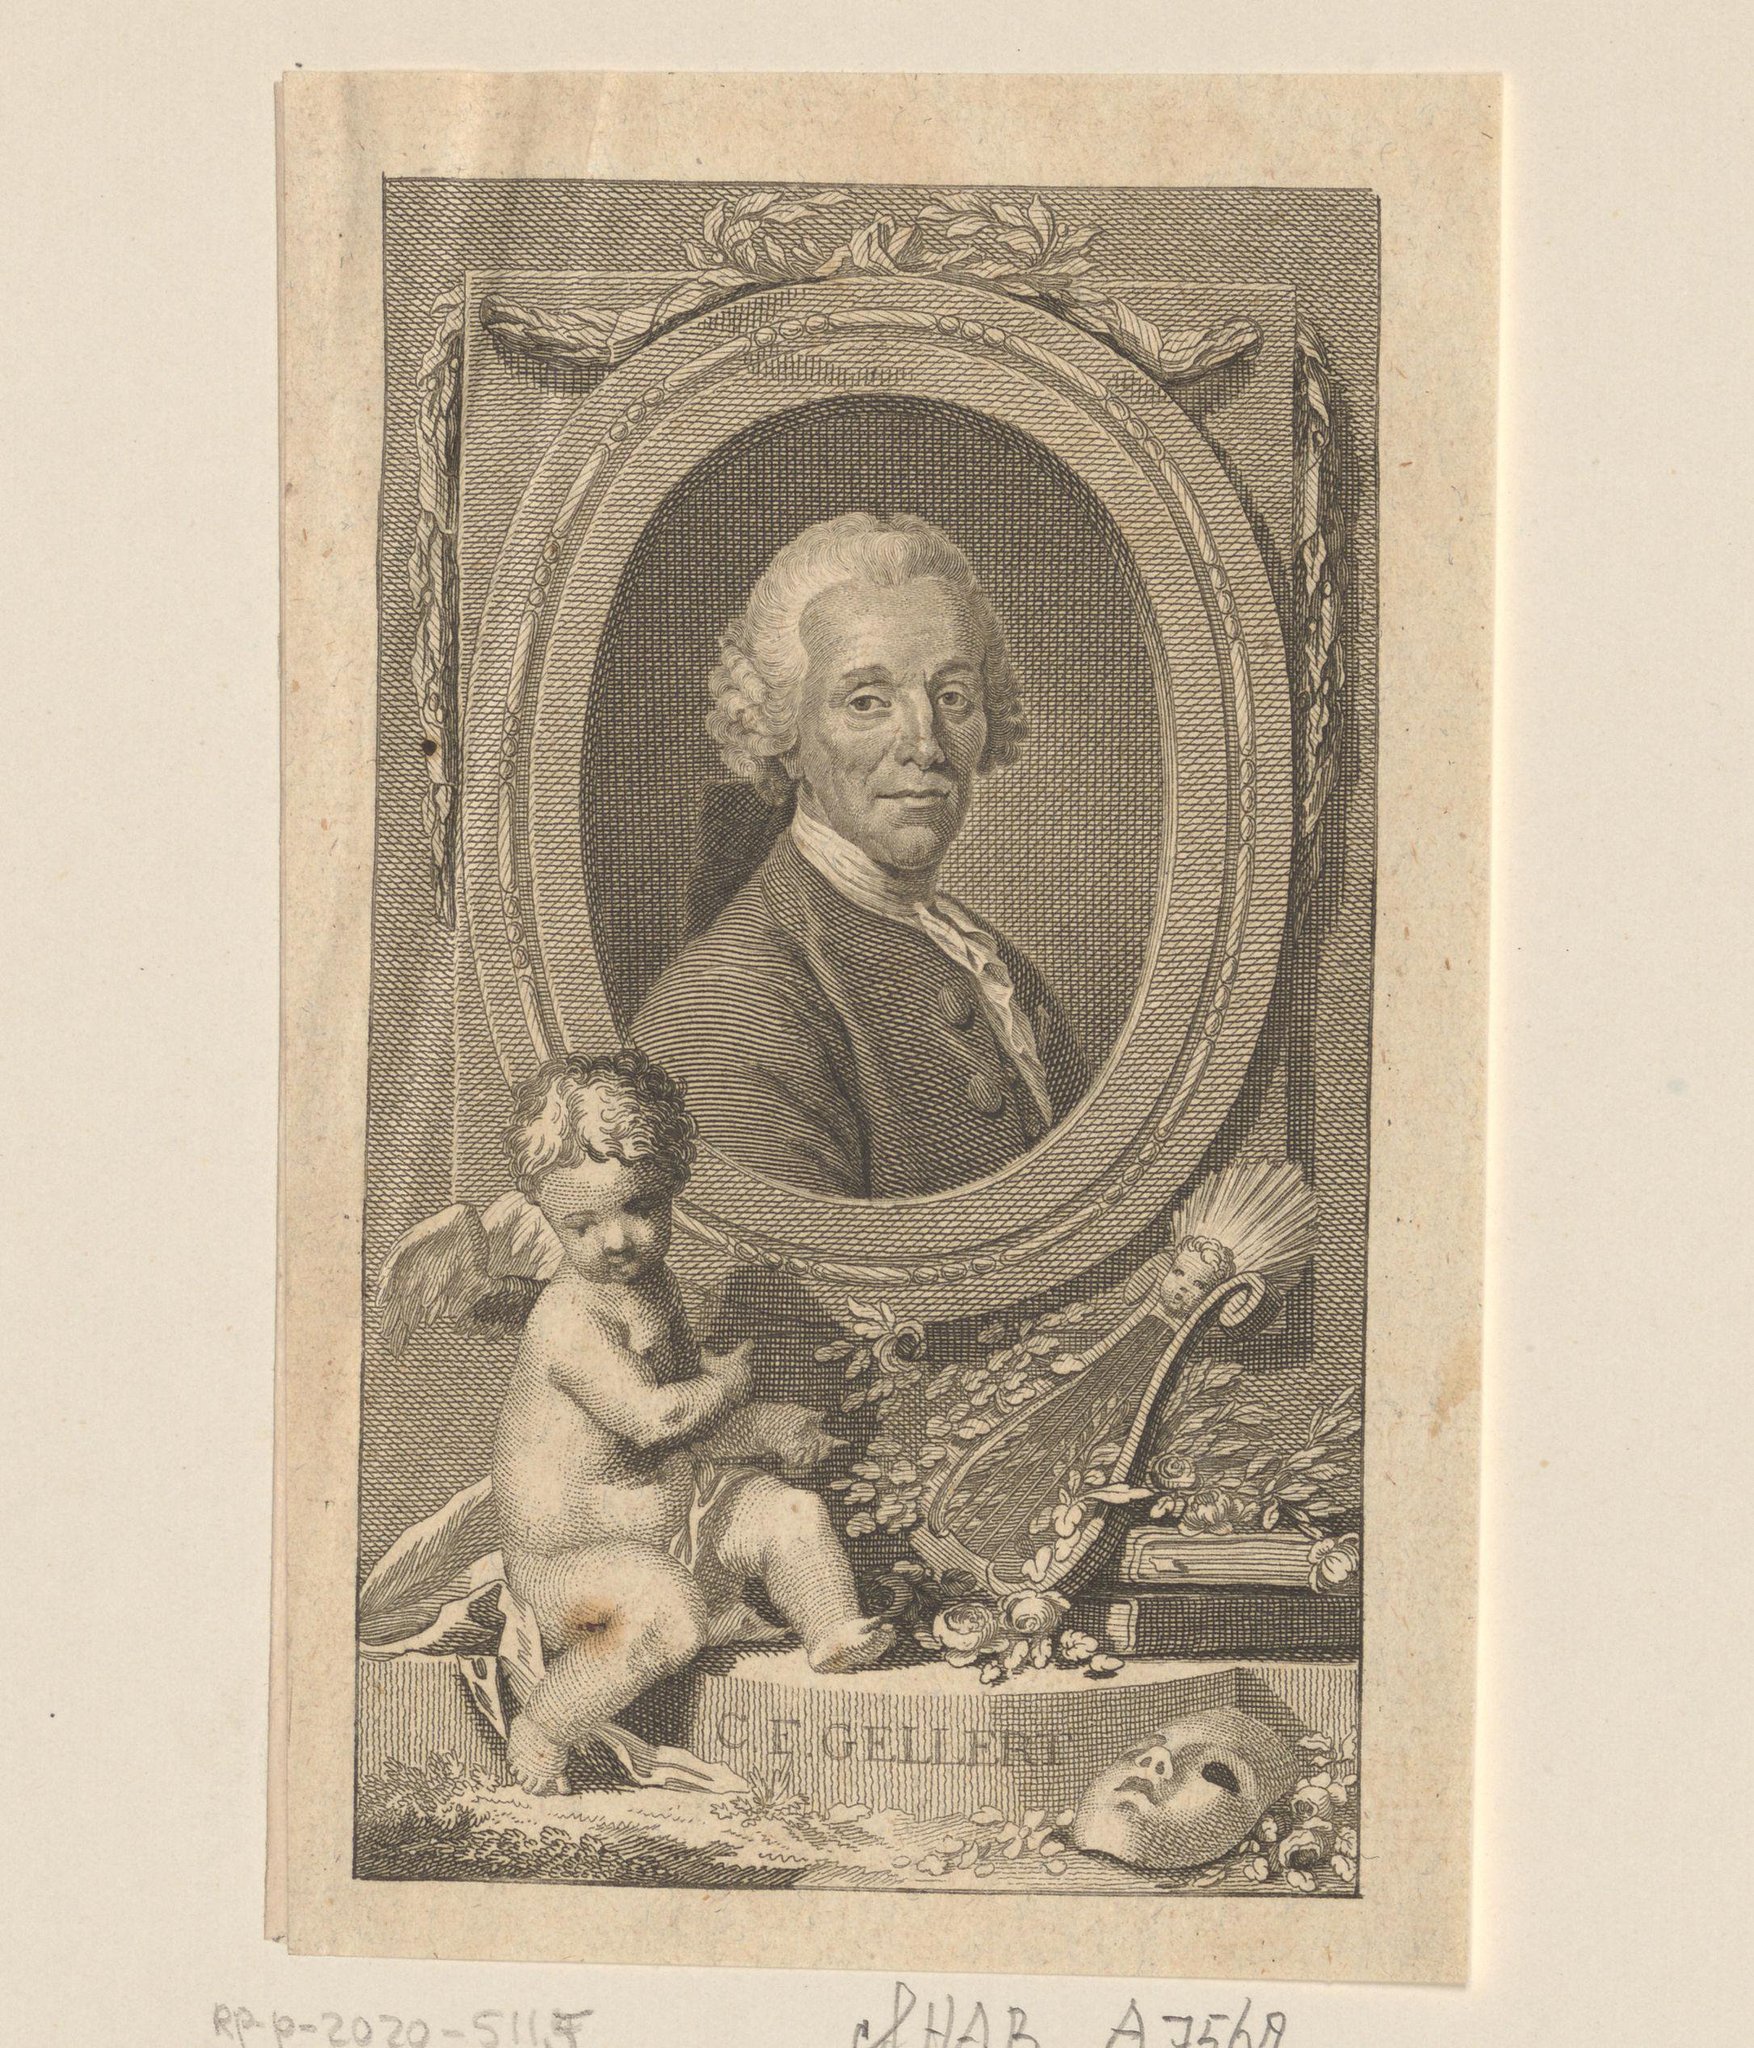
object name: print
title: Portret van Christian Furchtegott Gellert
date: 1748-1850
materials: paper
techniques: engraving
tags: lyre, cithara, psaltery, historical persons, writer, poet, author, cupids: 'amores', 'amoretti', 'putti'